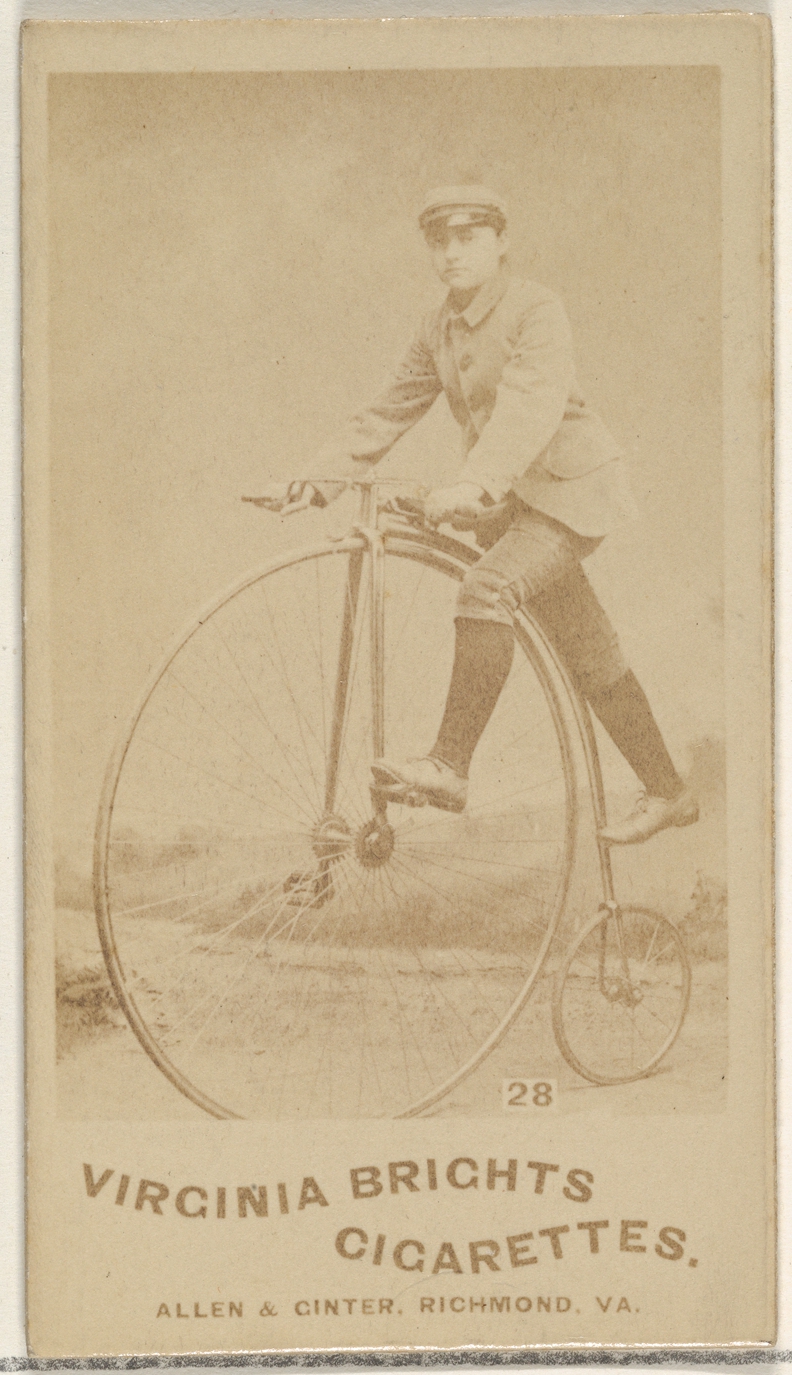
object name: photograph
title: Card 28, from the Girl Cyclists series (N49) for Virginia Brights Cigarettes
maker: allen & ginter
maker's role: publisher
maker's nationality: american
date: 1887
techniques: albumen silver print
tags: women,bicycles